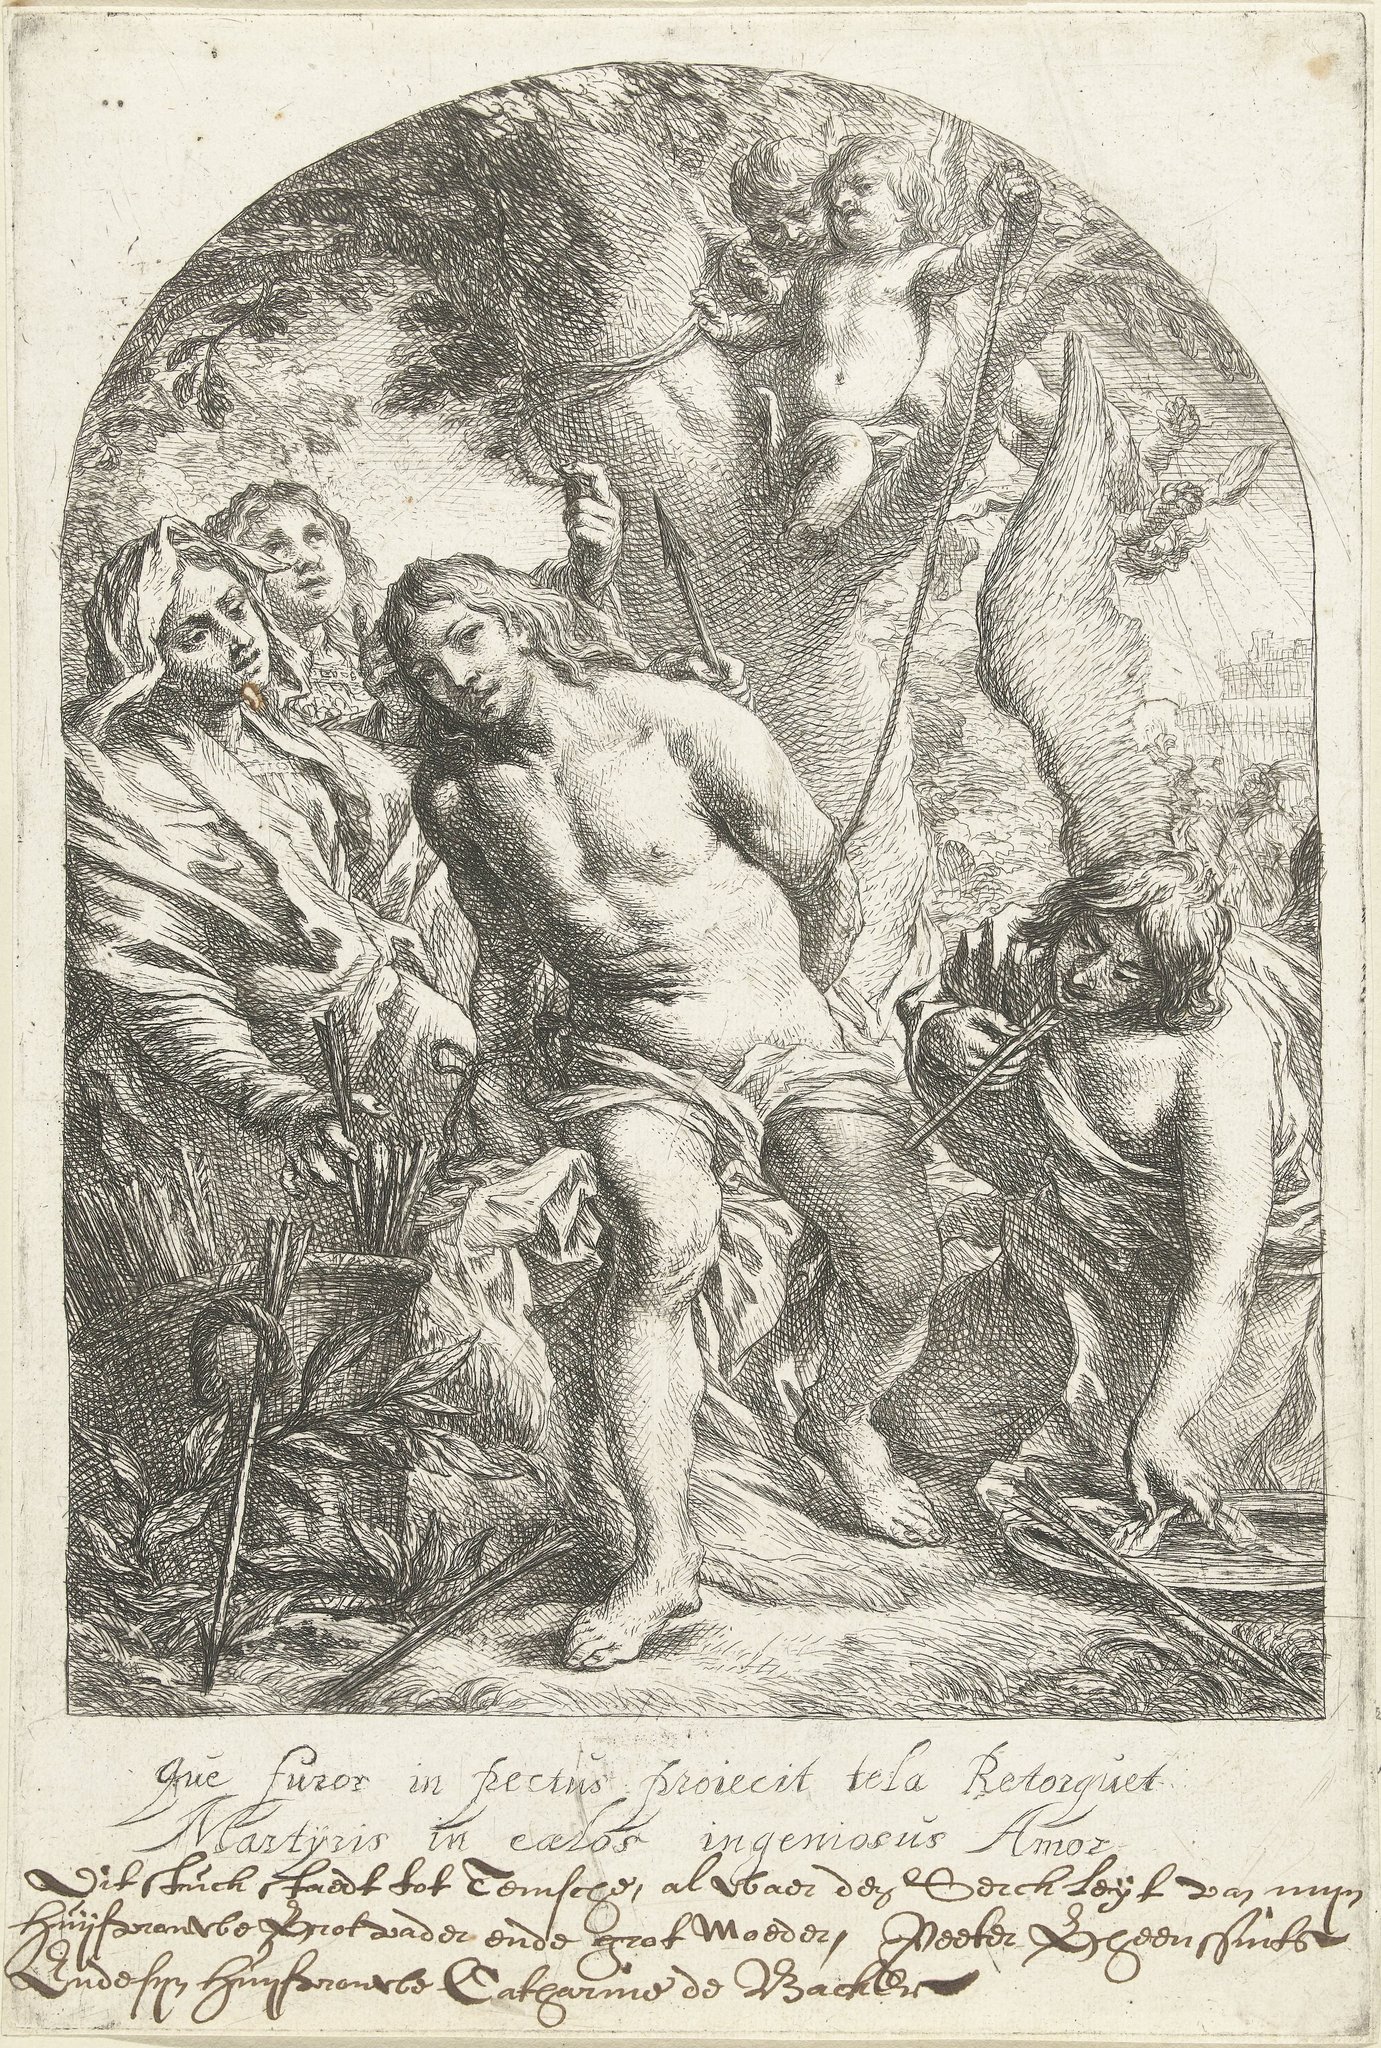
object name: print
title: H. Sebastiaan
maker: remoldus eynhoudts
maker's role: print maker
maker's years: 1613-1680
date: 1626-1680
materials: paper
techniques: etching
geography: antwerp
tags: the martyr sebastian; possible attributes: arrow(s), bow, tree-trunk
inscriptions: collector's mark: Lugt 240, inscription: ‘Dit Stuck staedt tot Temsche, alwaer den Serck leijt van myn huijsvrouwe Grotvater ende grot Moeder, Peeter Lheenwints (?) (end heenkints?) Ende syn huysvrouwe Catharine de Backer’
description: De heilige Sebastiaan is met zijn armen vastgebonden aan een boom. Een pijl doorboort zijn been. Naast hem twee personen en een mand met pijlen, aan de andere kant een engel die zijn wonden verzorgt. Onder de voorstelling twee regels Latijn en een Nederlands opschrift in drie regels.